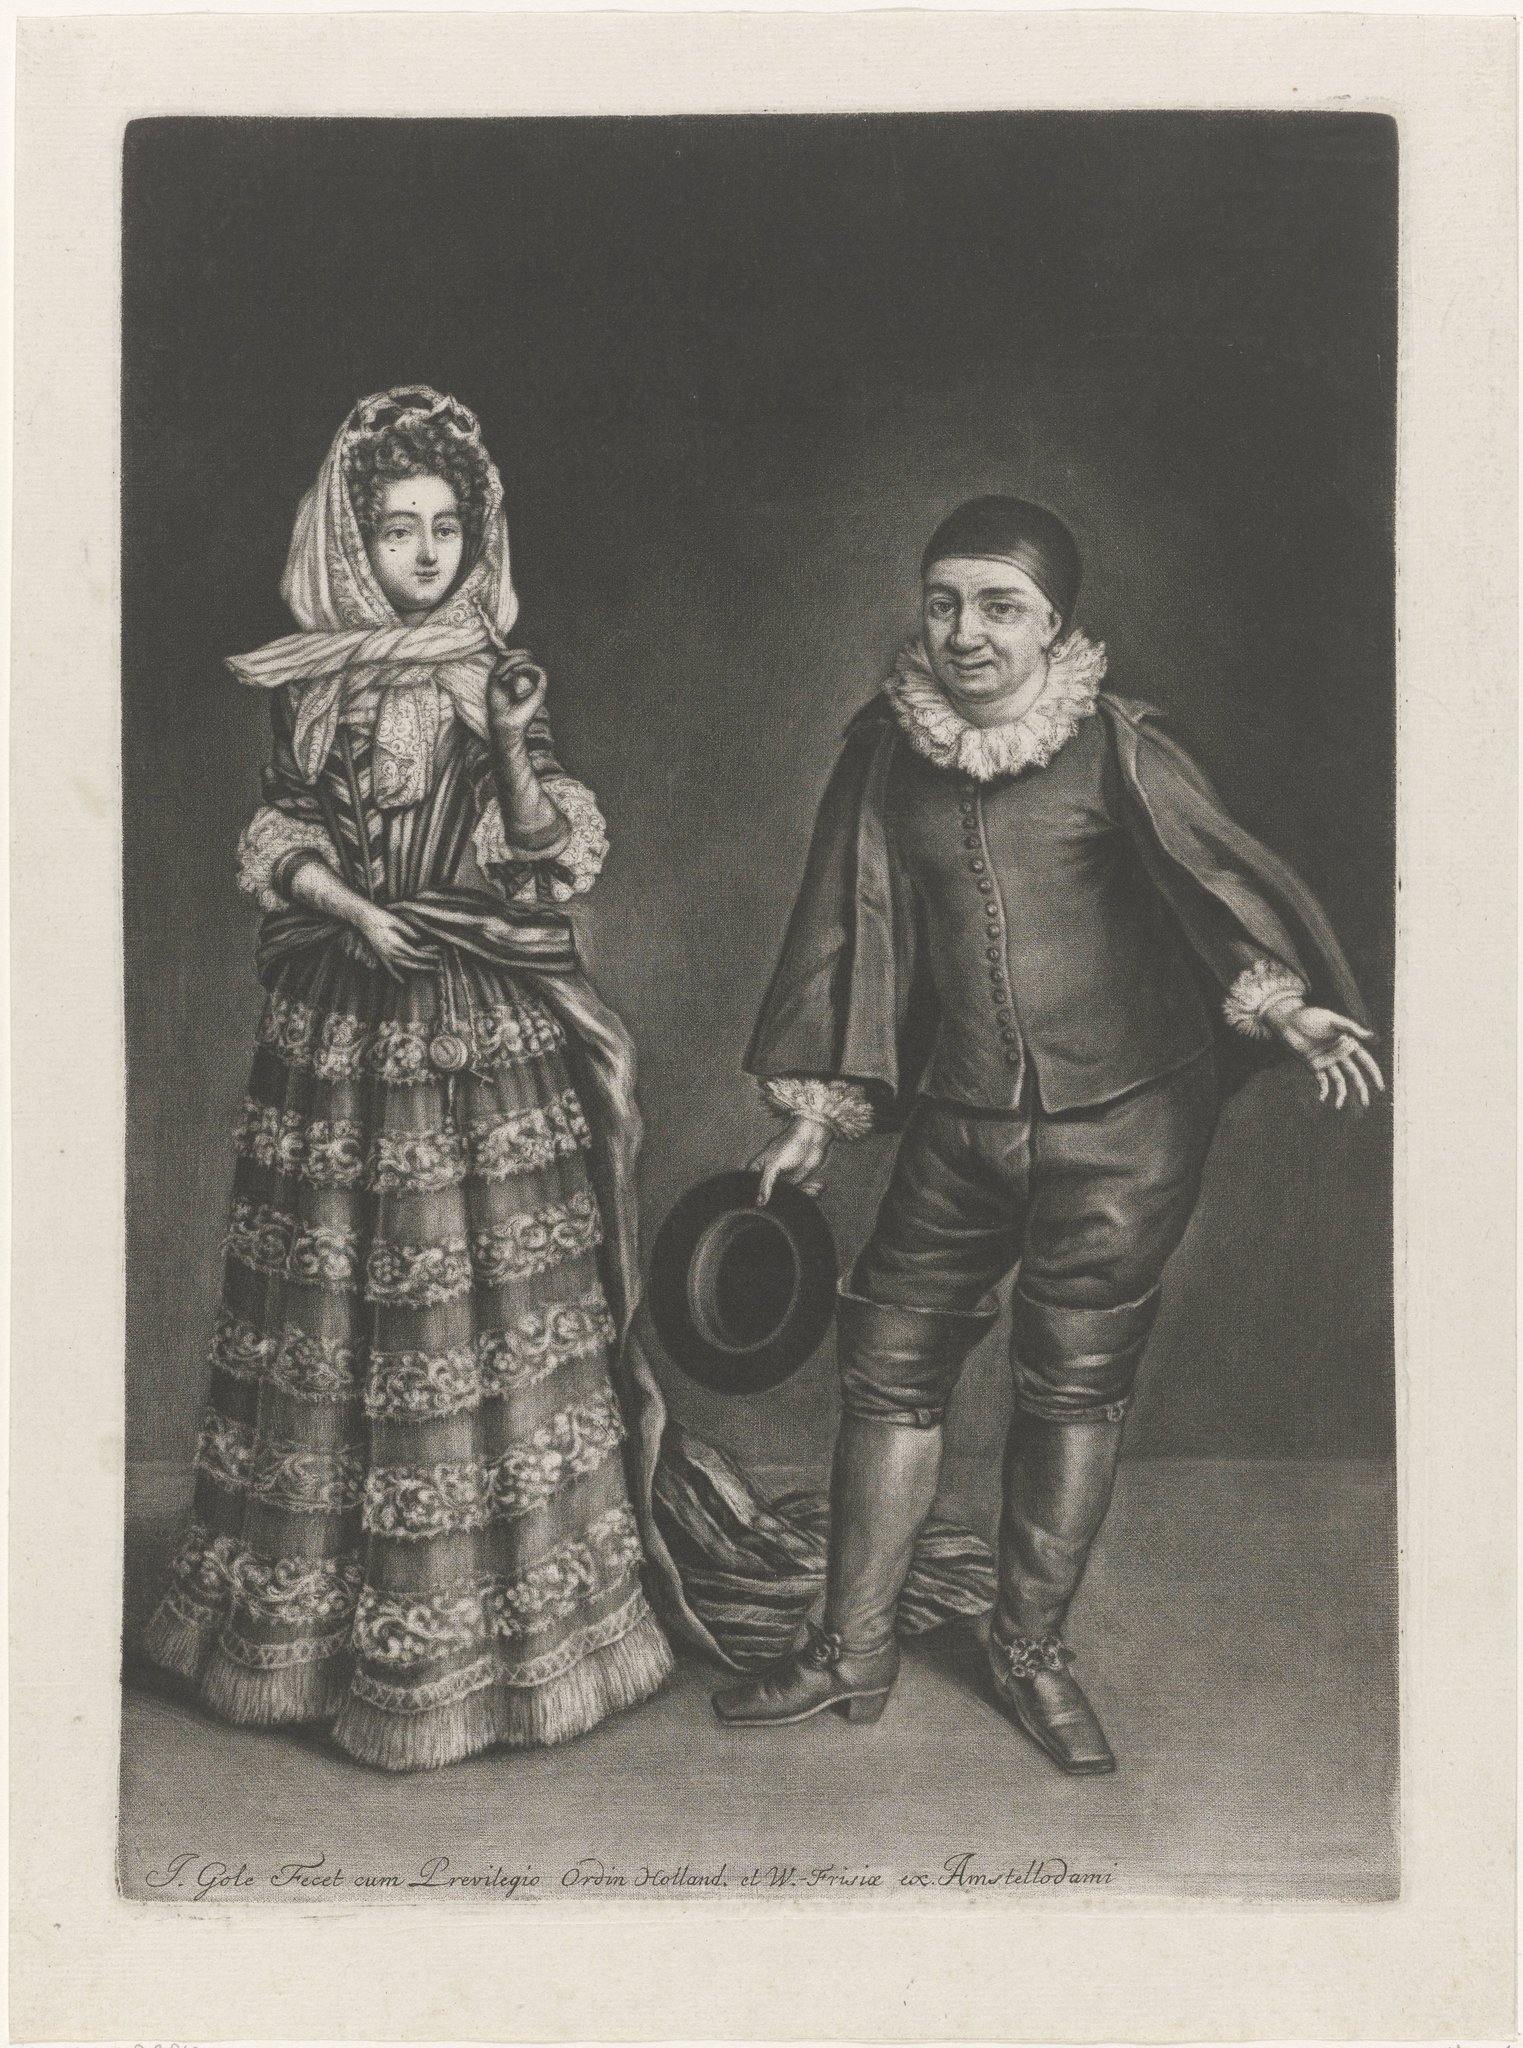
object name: print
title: Raymond Poisson en een actrice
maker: jacob gole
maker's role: print maker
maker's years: 1660-1724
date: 1670-1724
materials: paper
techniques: engraving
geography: amsterdam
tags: actor (on the stage), actor, actress (non-work situations)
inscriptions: collector's mark: Lugt 2228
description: De zeventiende-eeuwse Franse acteur Raymond Poisson, ook wel bekend als Belleroche, afgebeeld als zijn meest bekende personage, Krispijn. Naast hem een actrice.